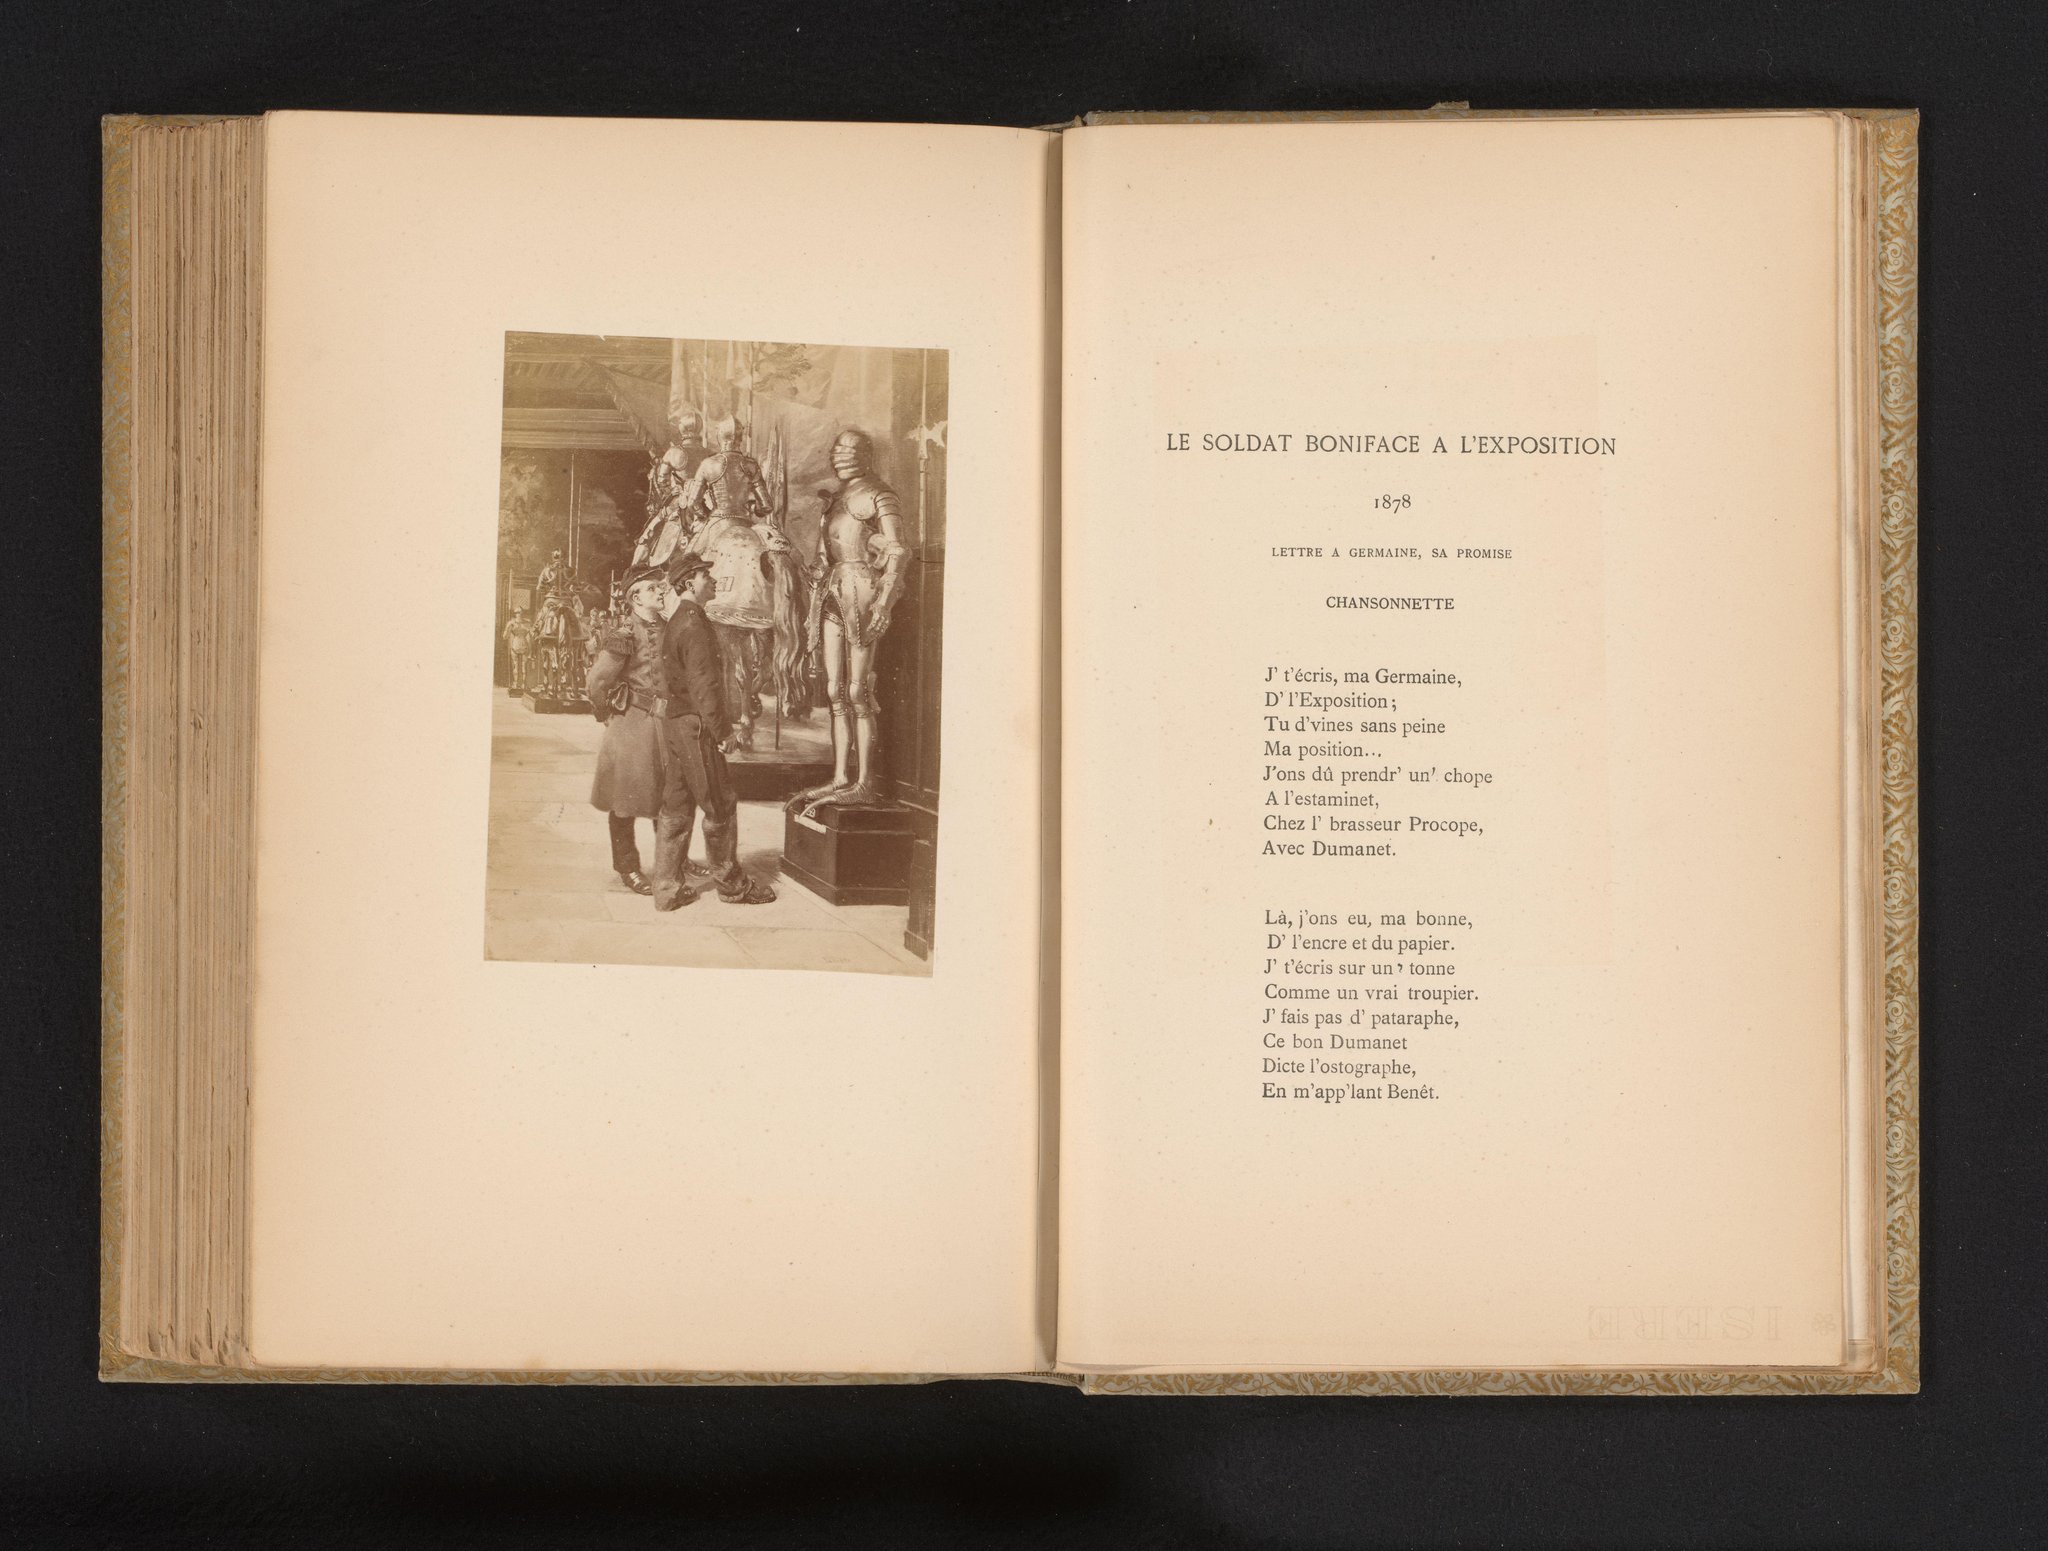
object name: reproduction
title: Fotoreproductie van een schilderij van bezoekers bij een tentoonstelling van harnassen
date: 1874-1884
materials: paper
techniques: albumen print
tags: armour, picture, painting, collection, exhibition, show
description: Foto op tweede ongenummerde pagina op pagina 254.